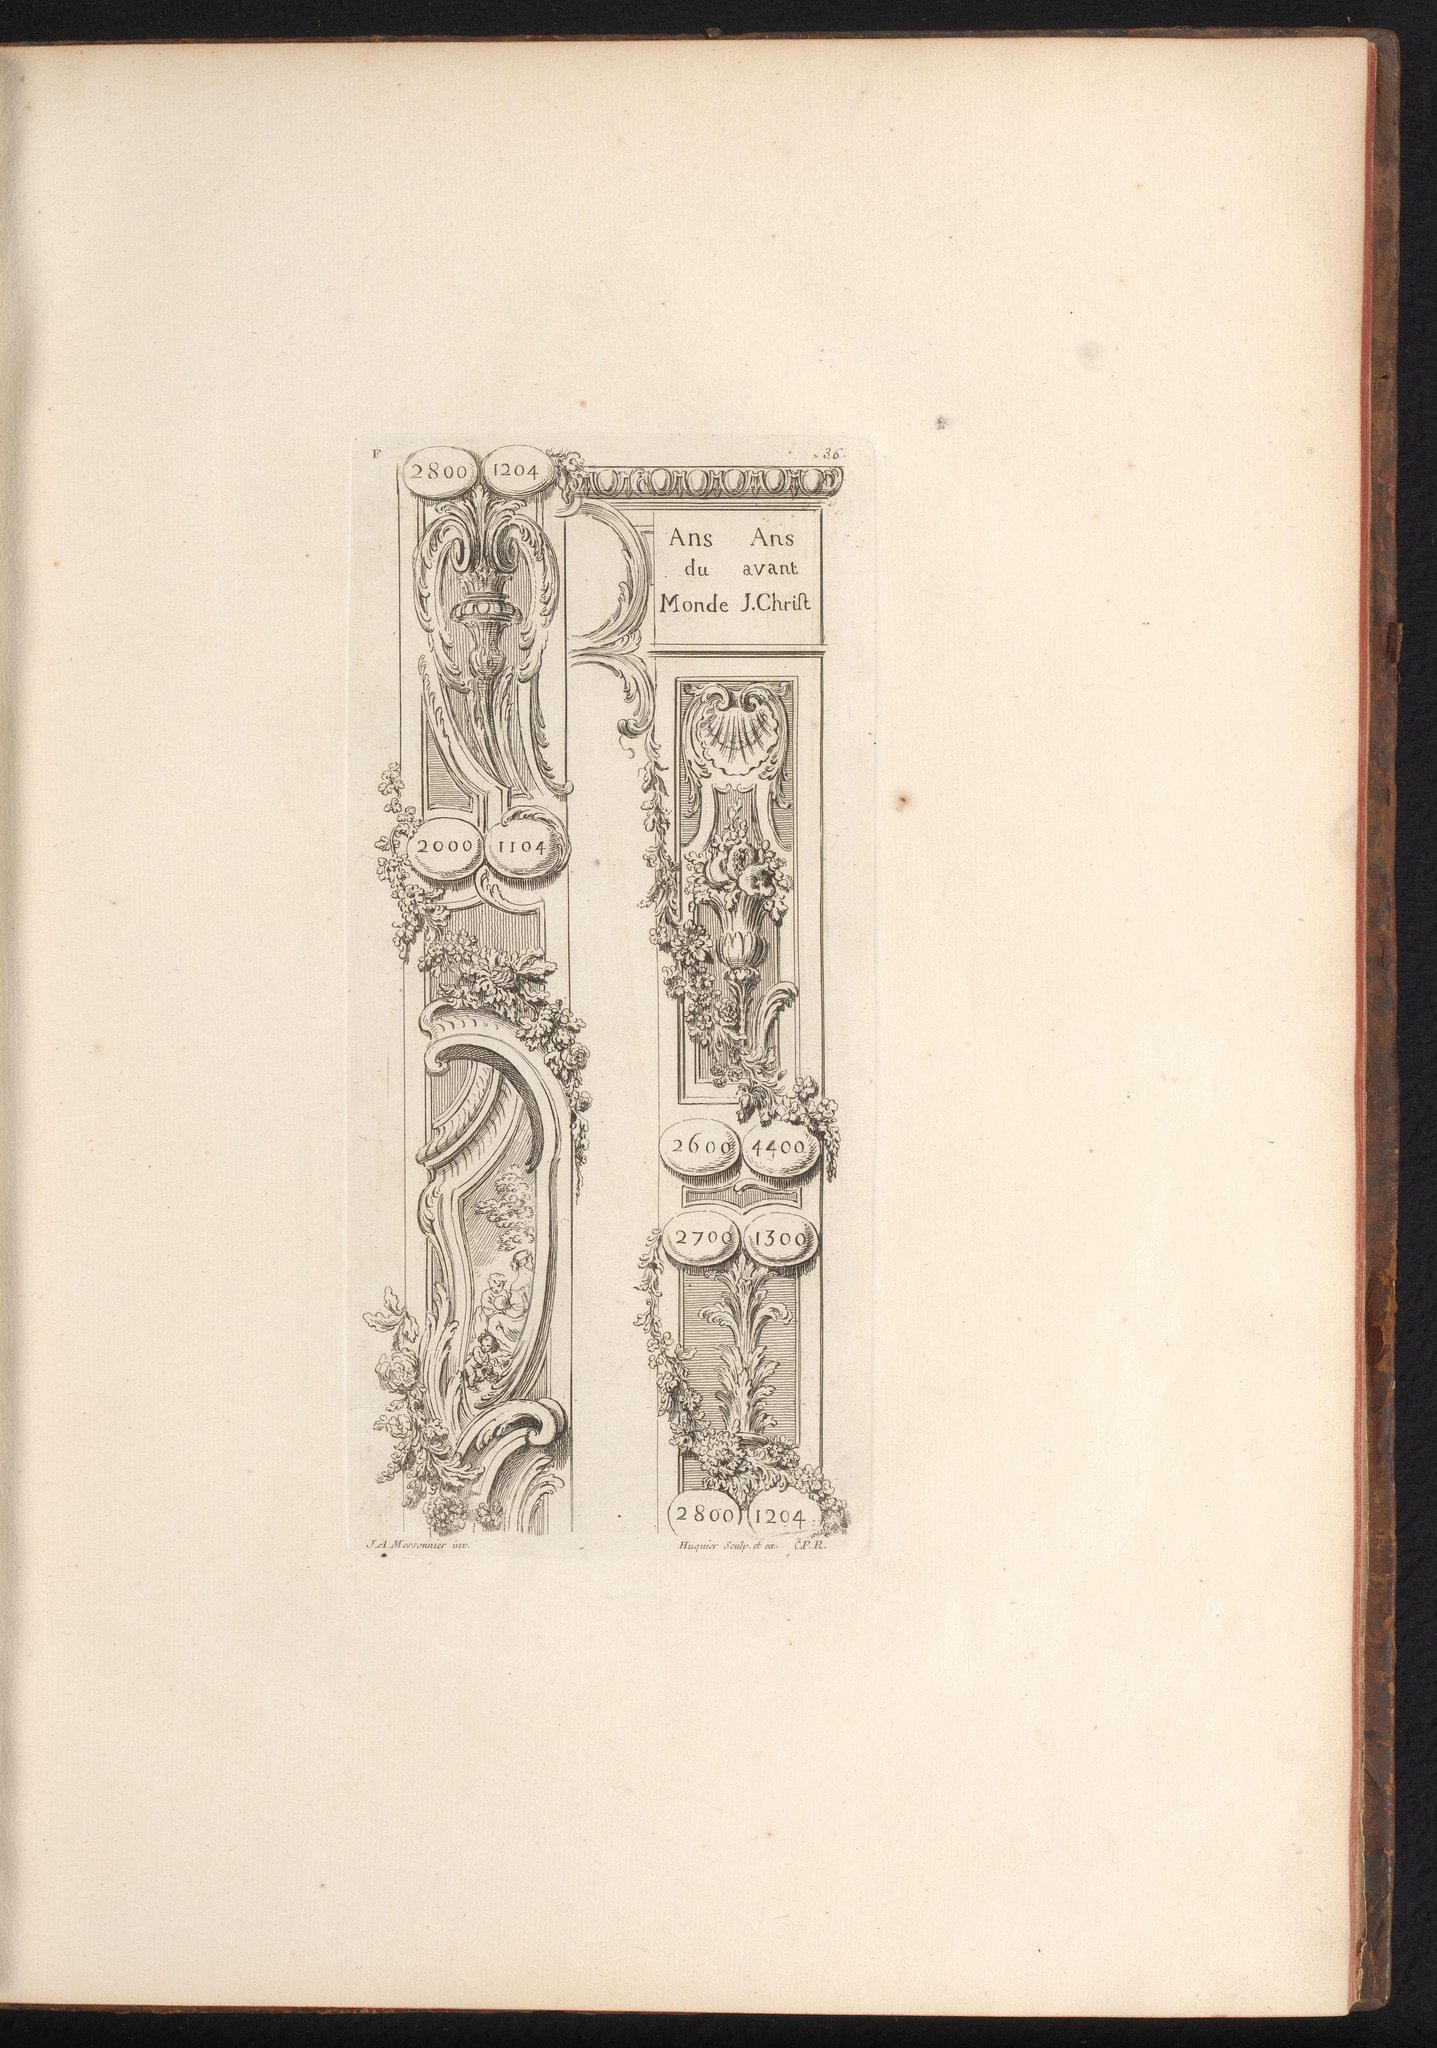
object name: print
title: Oeuvre van Juste Aurele Meissonnier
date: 1738-1749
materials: paper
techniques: etching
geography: paris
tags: ornament derived from architectural details, ornament ~ festoon, garland, ornament derived from plant forms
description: Fragmenten van de ornamentrand voor de "Carte chronologique du roy". Deze prent maakt deel uit van een album.